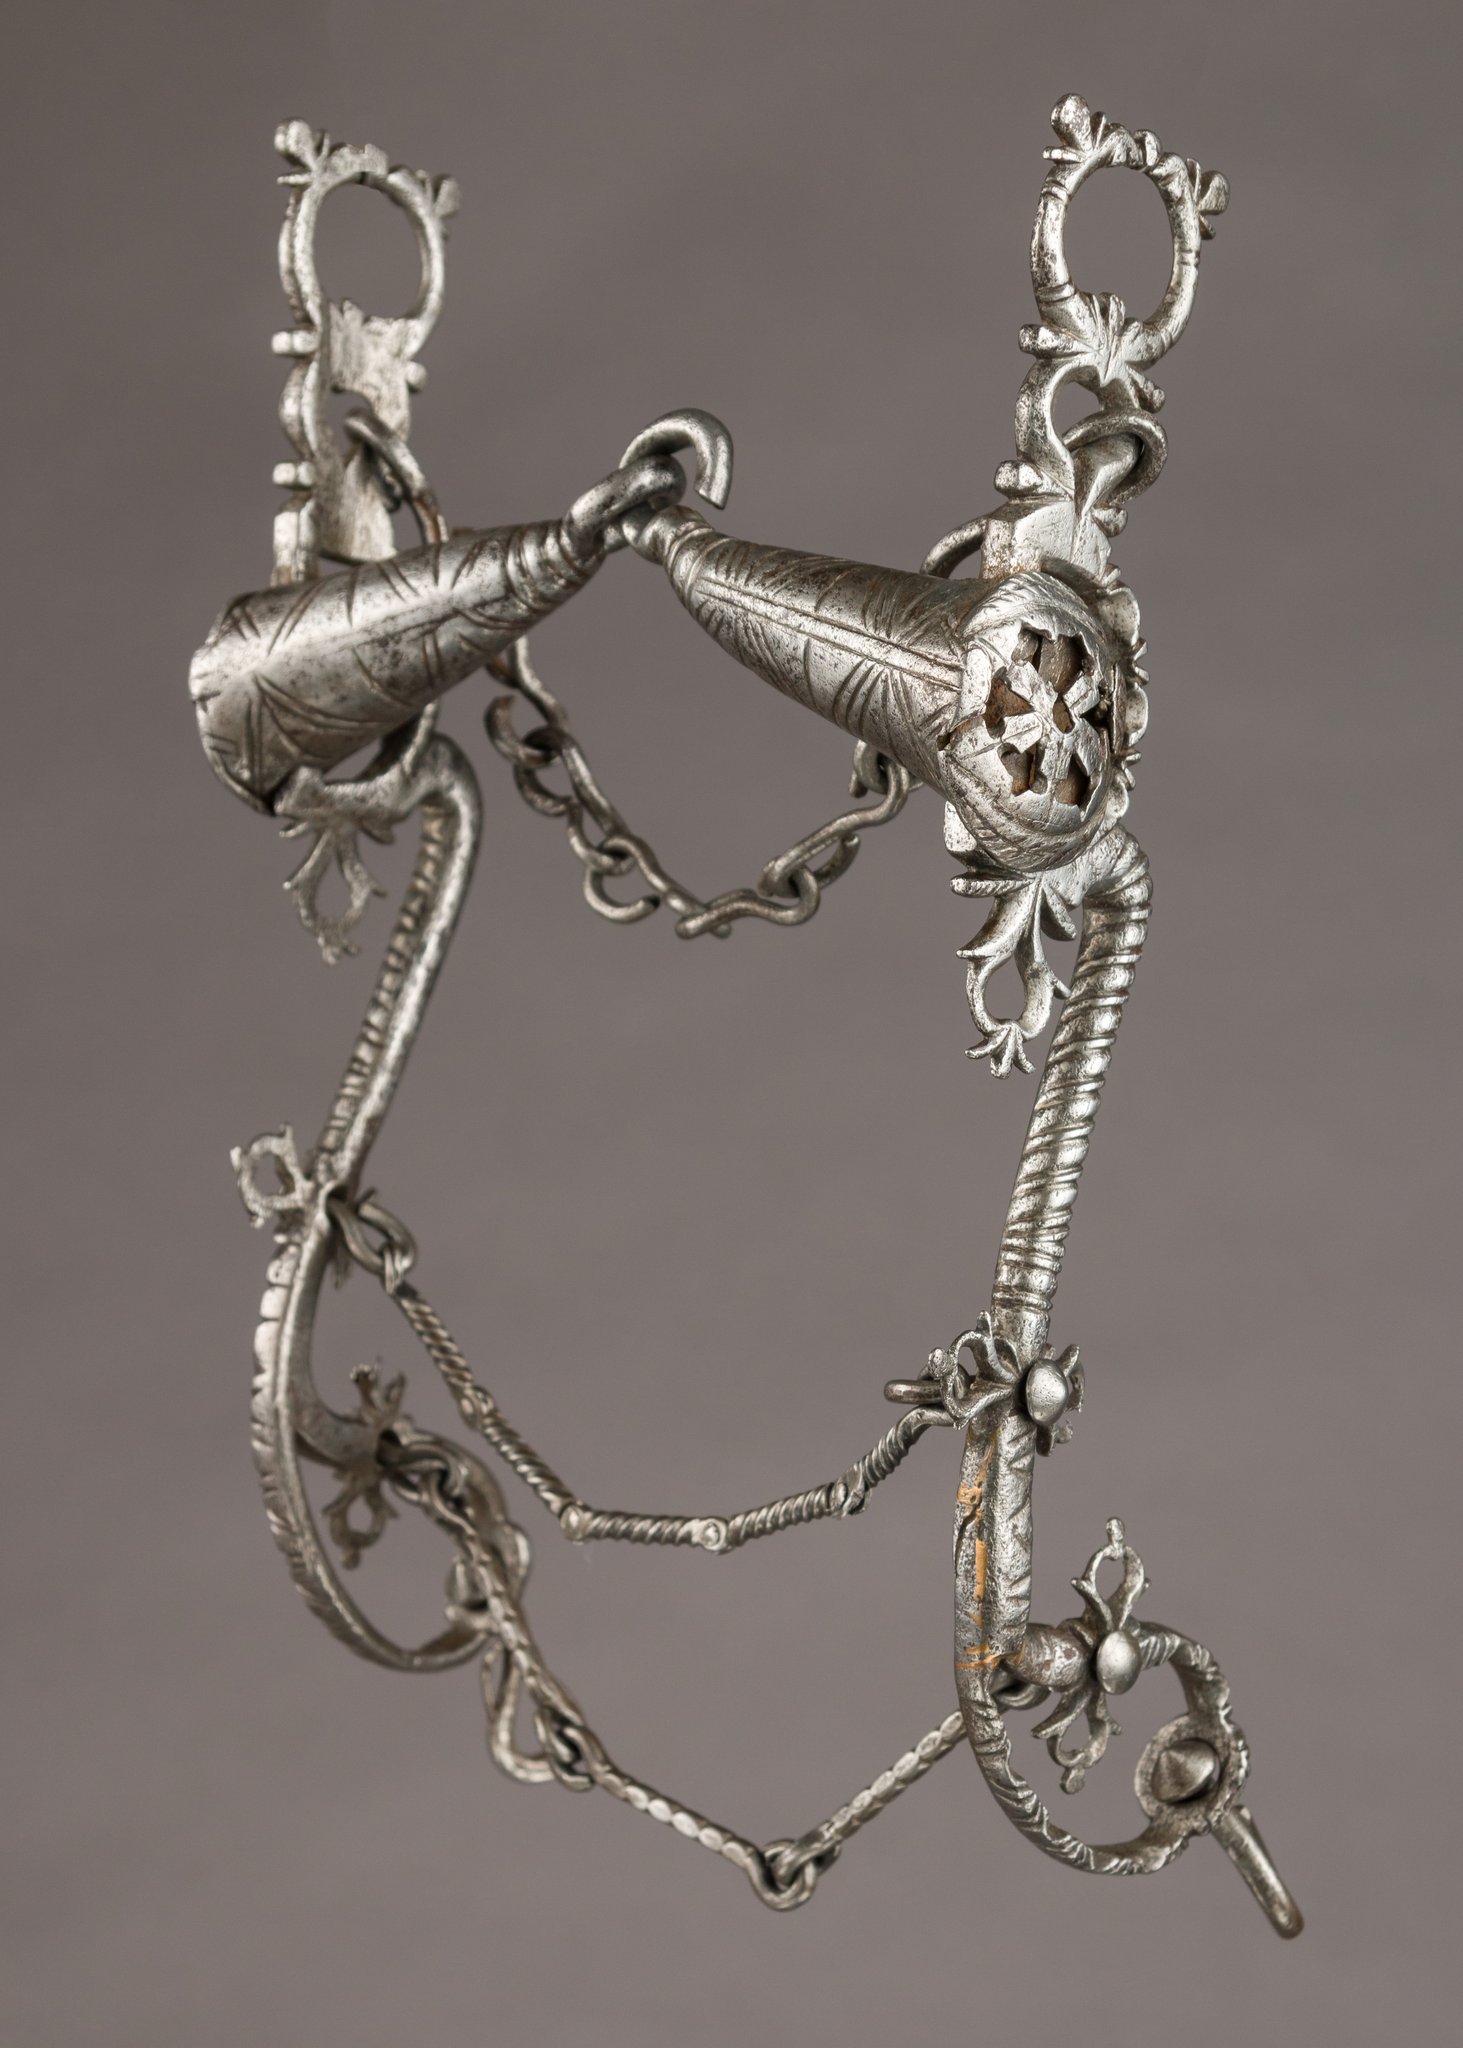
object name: bit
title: Curb Bit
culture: german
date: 1601-1700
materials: copper, metal alloy, tin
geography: germany